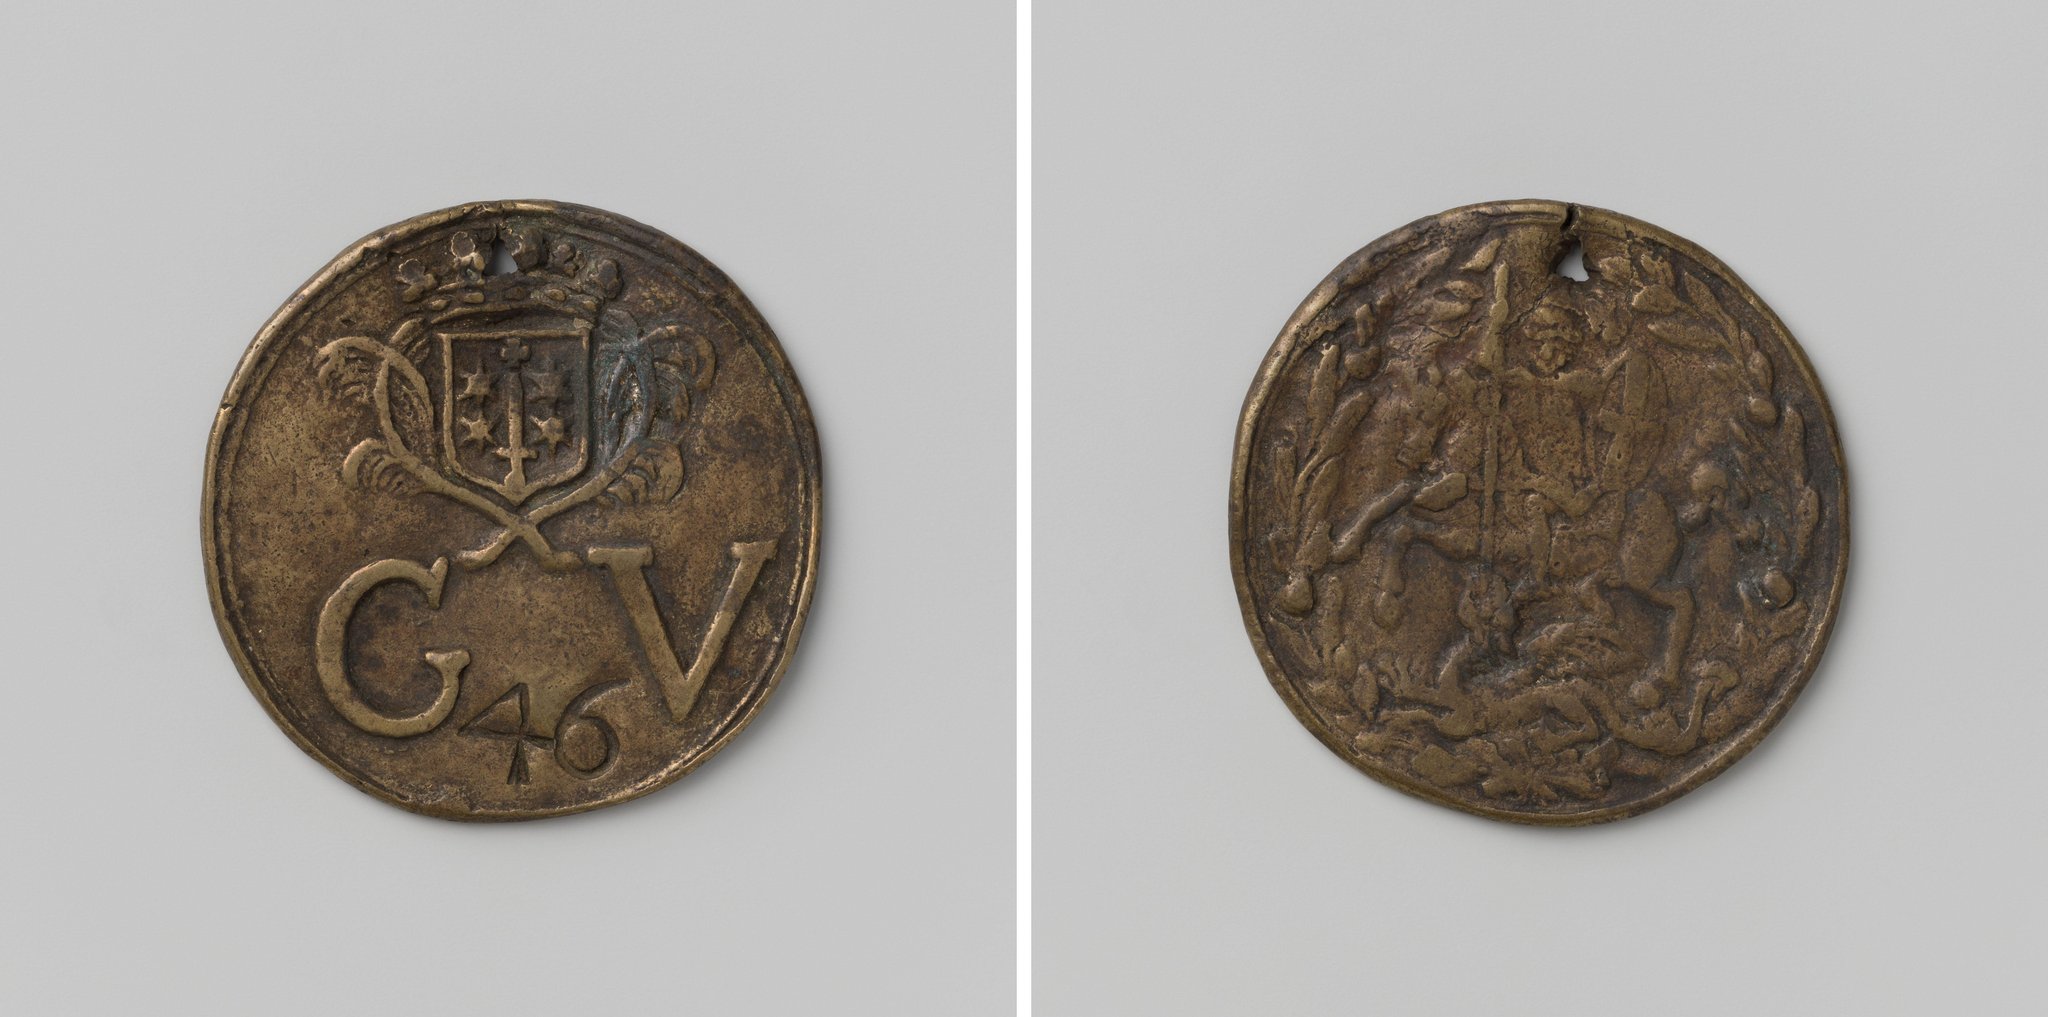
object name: marksman medal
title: Schutterij van Haarlem, schutterspenning van het Gele Vaandel met no. 46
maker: Anonymous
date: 1650-1750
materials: brass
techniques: casting, engraving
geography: haarlem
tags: haarlem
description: Messing penning. Voorzijde: gekroond wapenschild op twee gekruiste palmtakken boven letters G en V; daartussen: cijfer 46. Keerzijde: gehelmde St. Joris te paard met schild in linkerhand doodt met speer ter aarde liggende draak